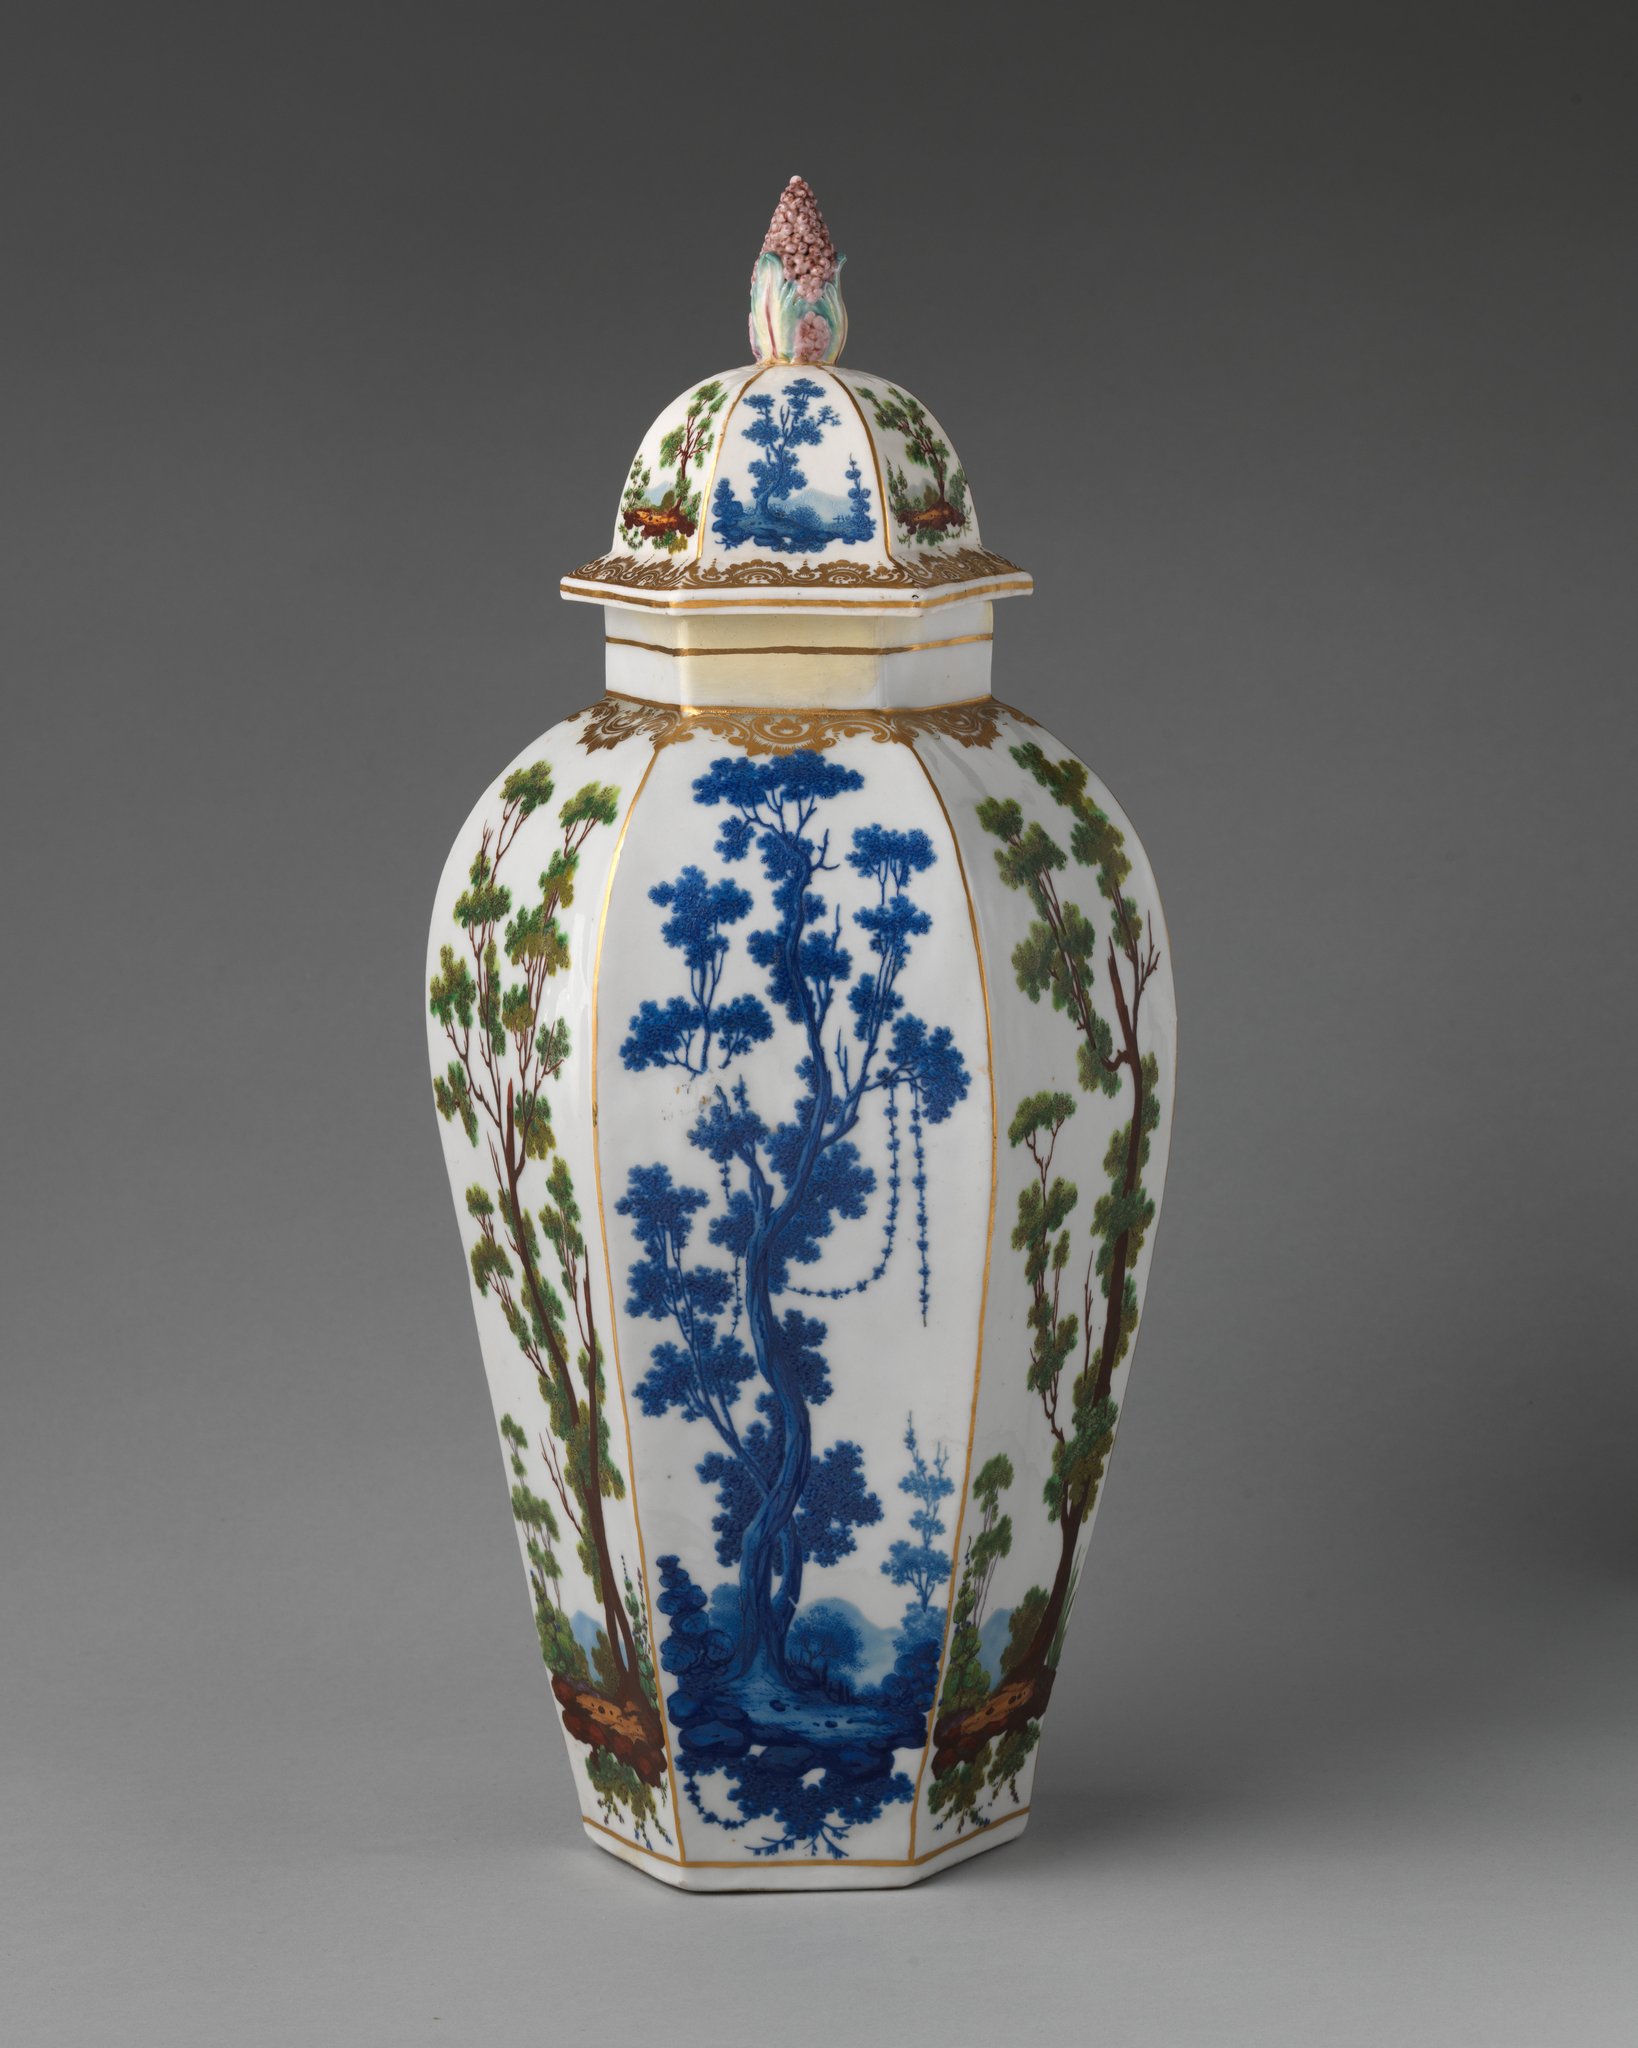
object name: vase with cover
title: Vase with cover (part of a garniture of three vases)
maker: bristol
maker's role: factory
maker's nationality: british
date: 1773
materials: hard paste porcelain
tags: trees